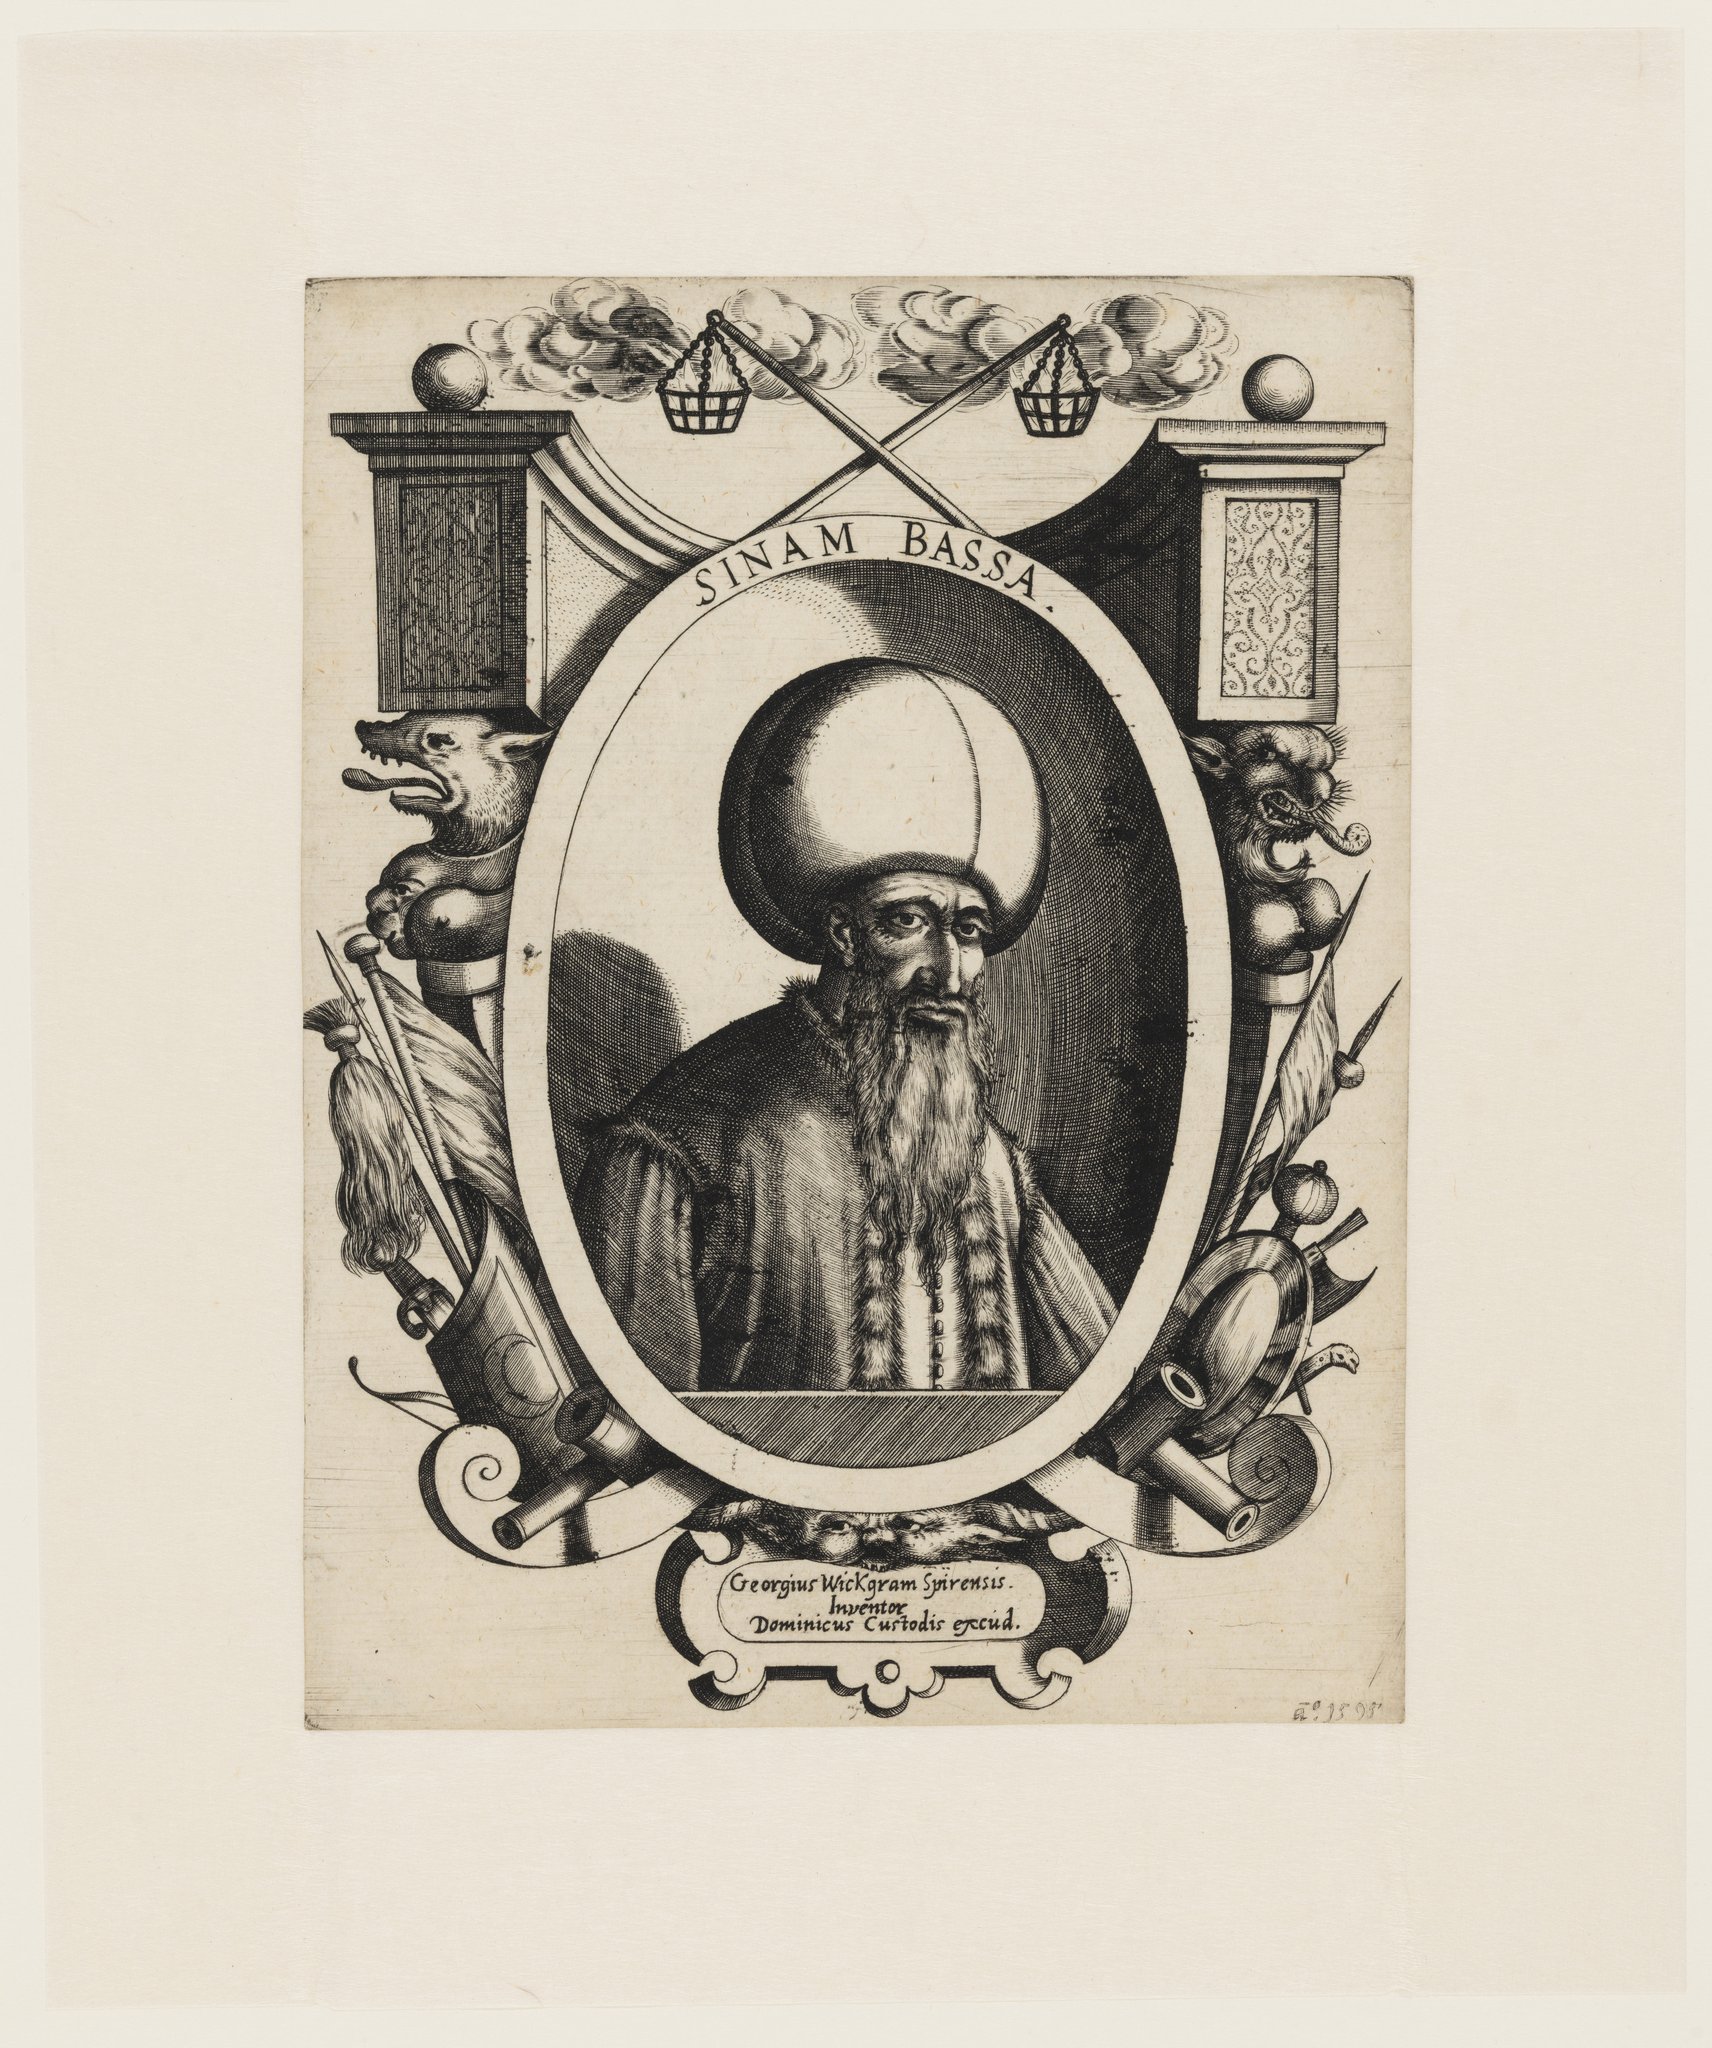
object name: print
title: Portrait of Sinan the Great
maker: dominicus custos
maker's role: artist and publisher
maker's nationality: german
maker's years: 1550-1612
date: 1595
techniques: engraving